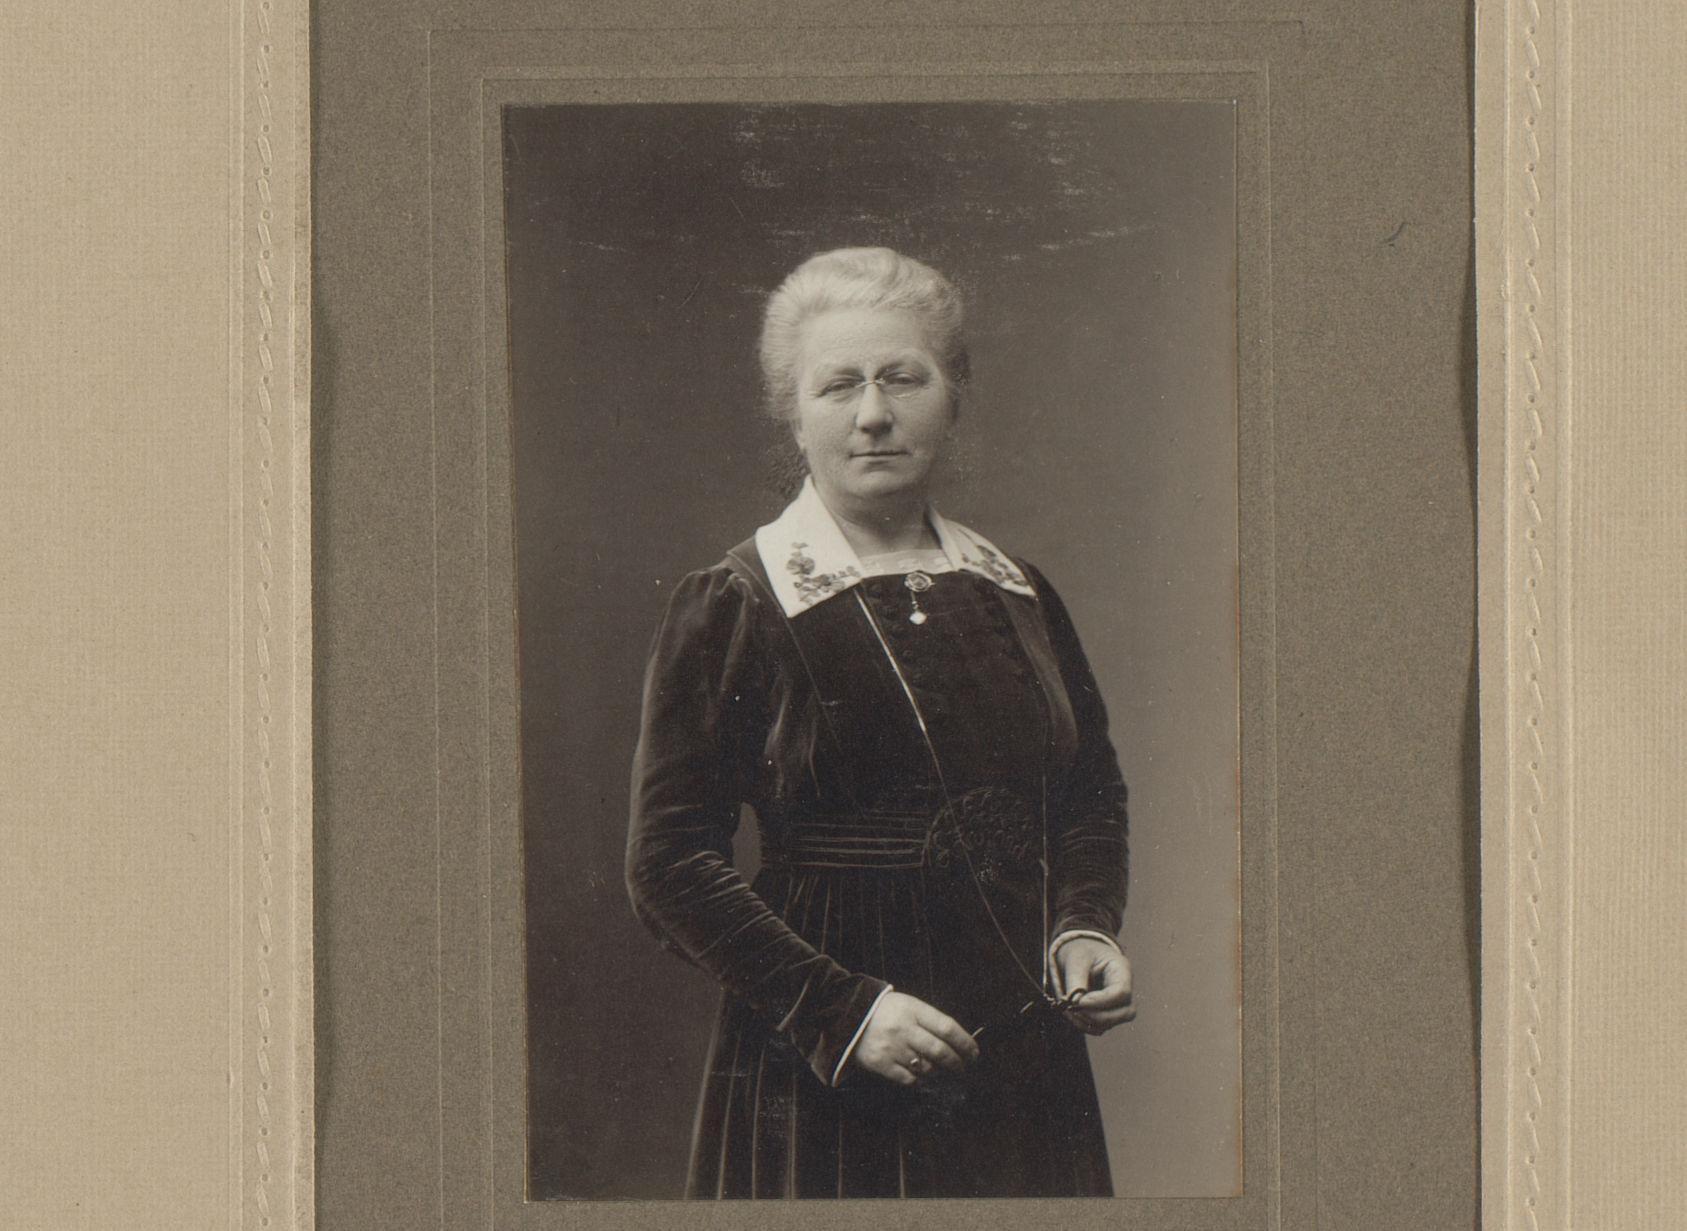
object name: photograph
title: Portret van Johanna P.C. Kessler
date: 1905-1918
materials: paper, photographic support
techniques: gelatin silver print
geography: netherlands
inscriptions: annotation: ‘Ongetrouwde zus van J.B.A Kessler, Johanna P.C. Kessler, mei 1918’